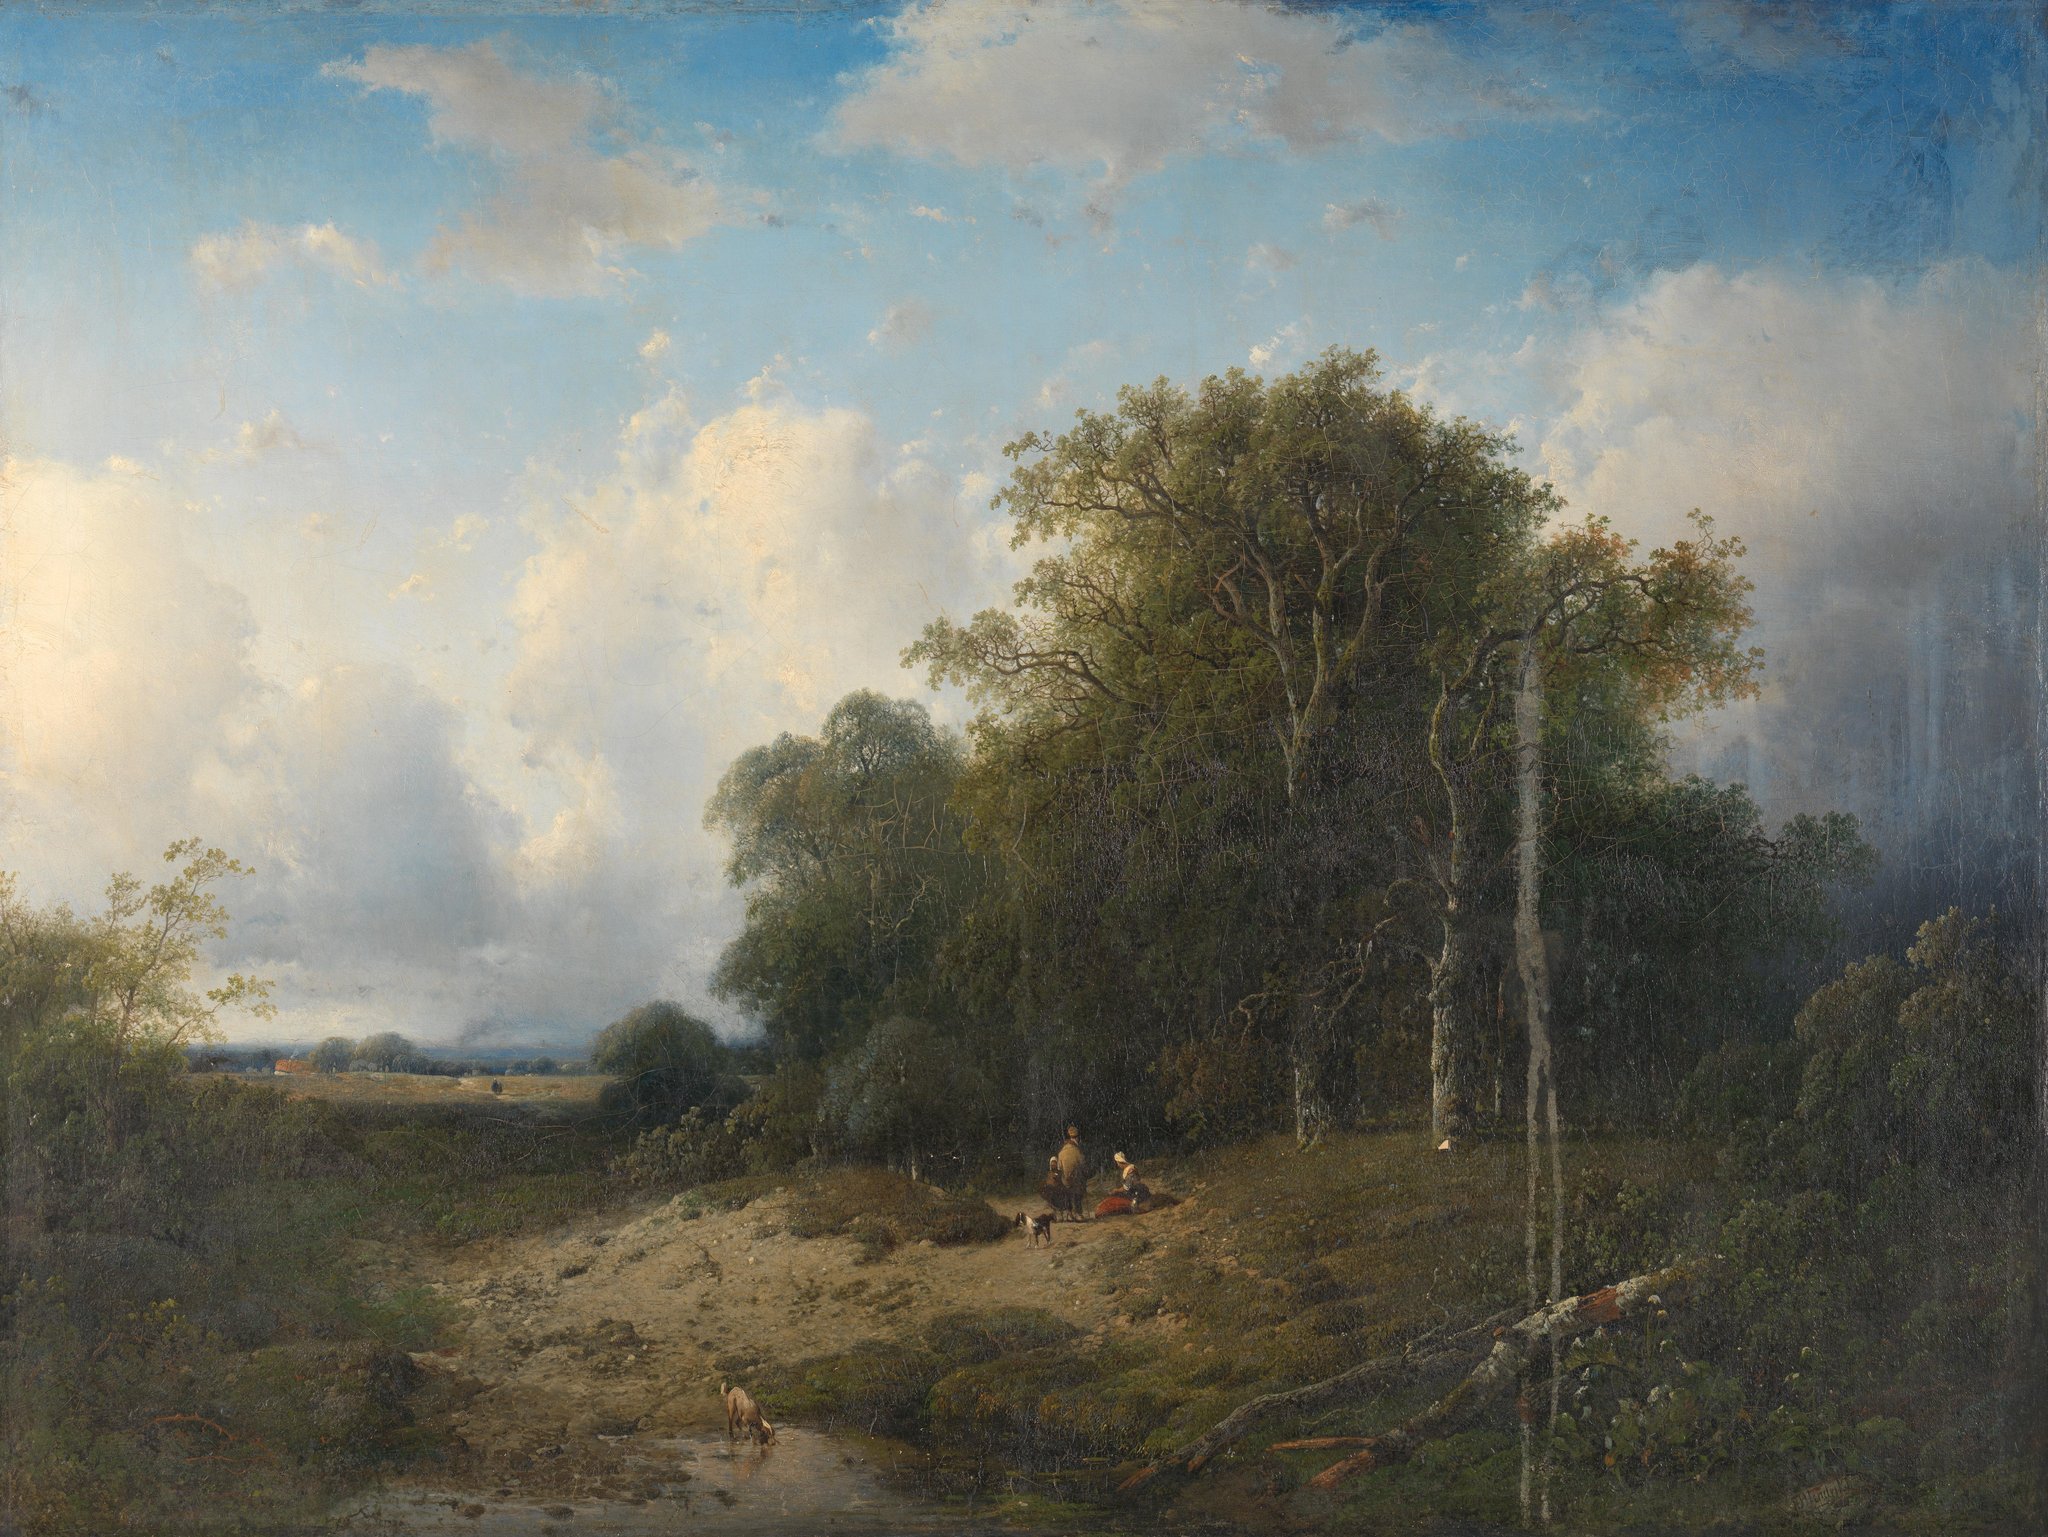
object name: painting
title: Landscape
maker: frederik hendrik hendriks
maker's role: painter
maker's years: 1808-1865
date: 1840-1865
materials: canvas, oil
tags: landscapes in the temperate zone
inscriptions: signature: ‘FHHendriks’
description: Landschap met een groep van drie personen naast een zandpad bij een bomengroep. Rechts struiken en een omgevallen boomstam, op de voorgrond drinkt een hond uit een plas.